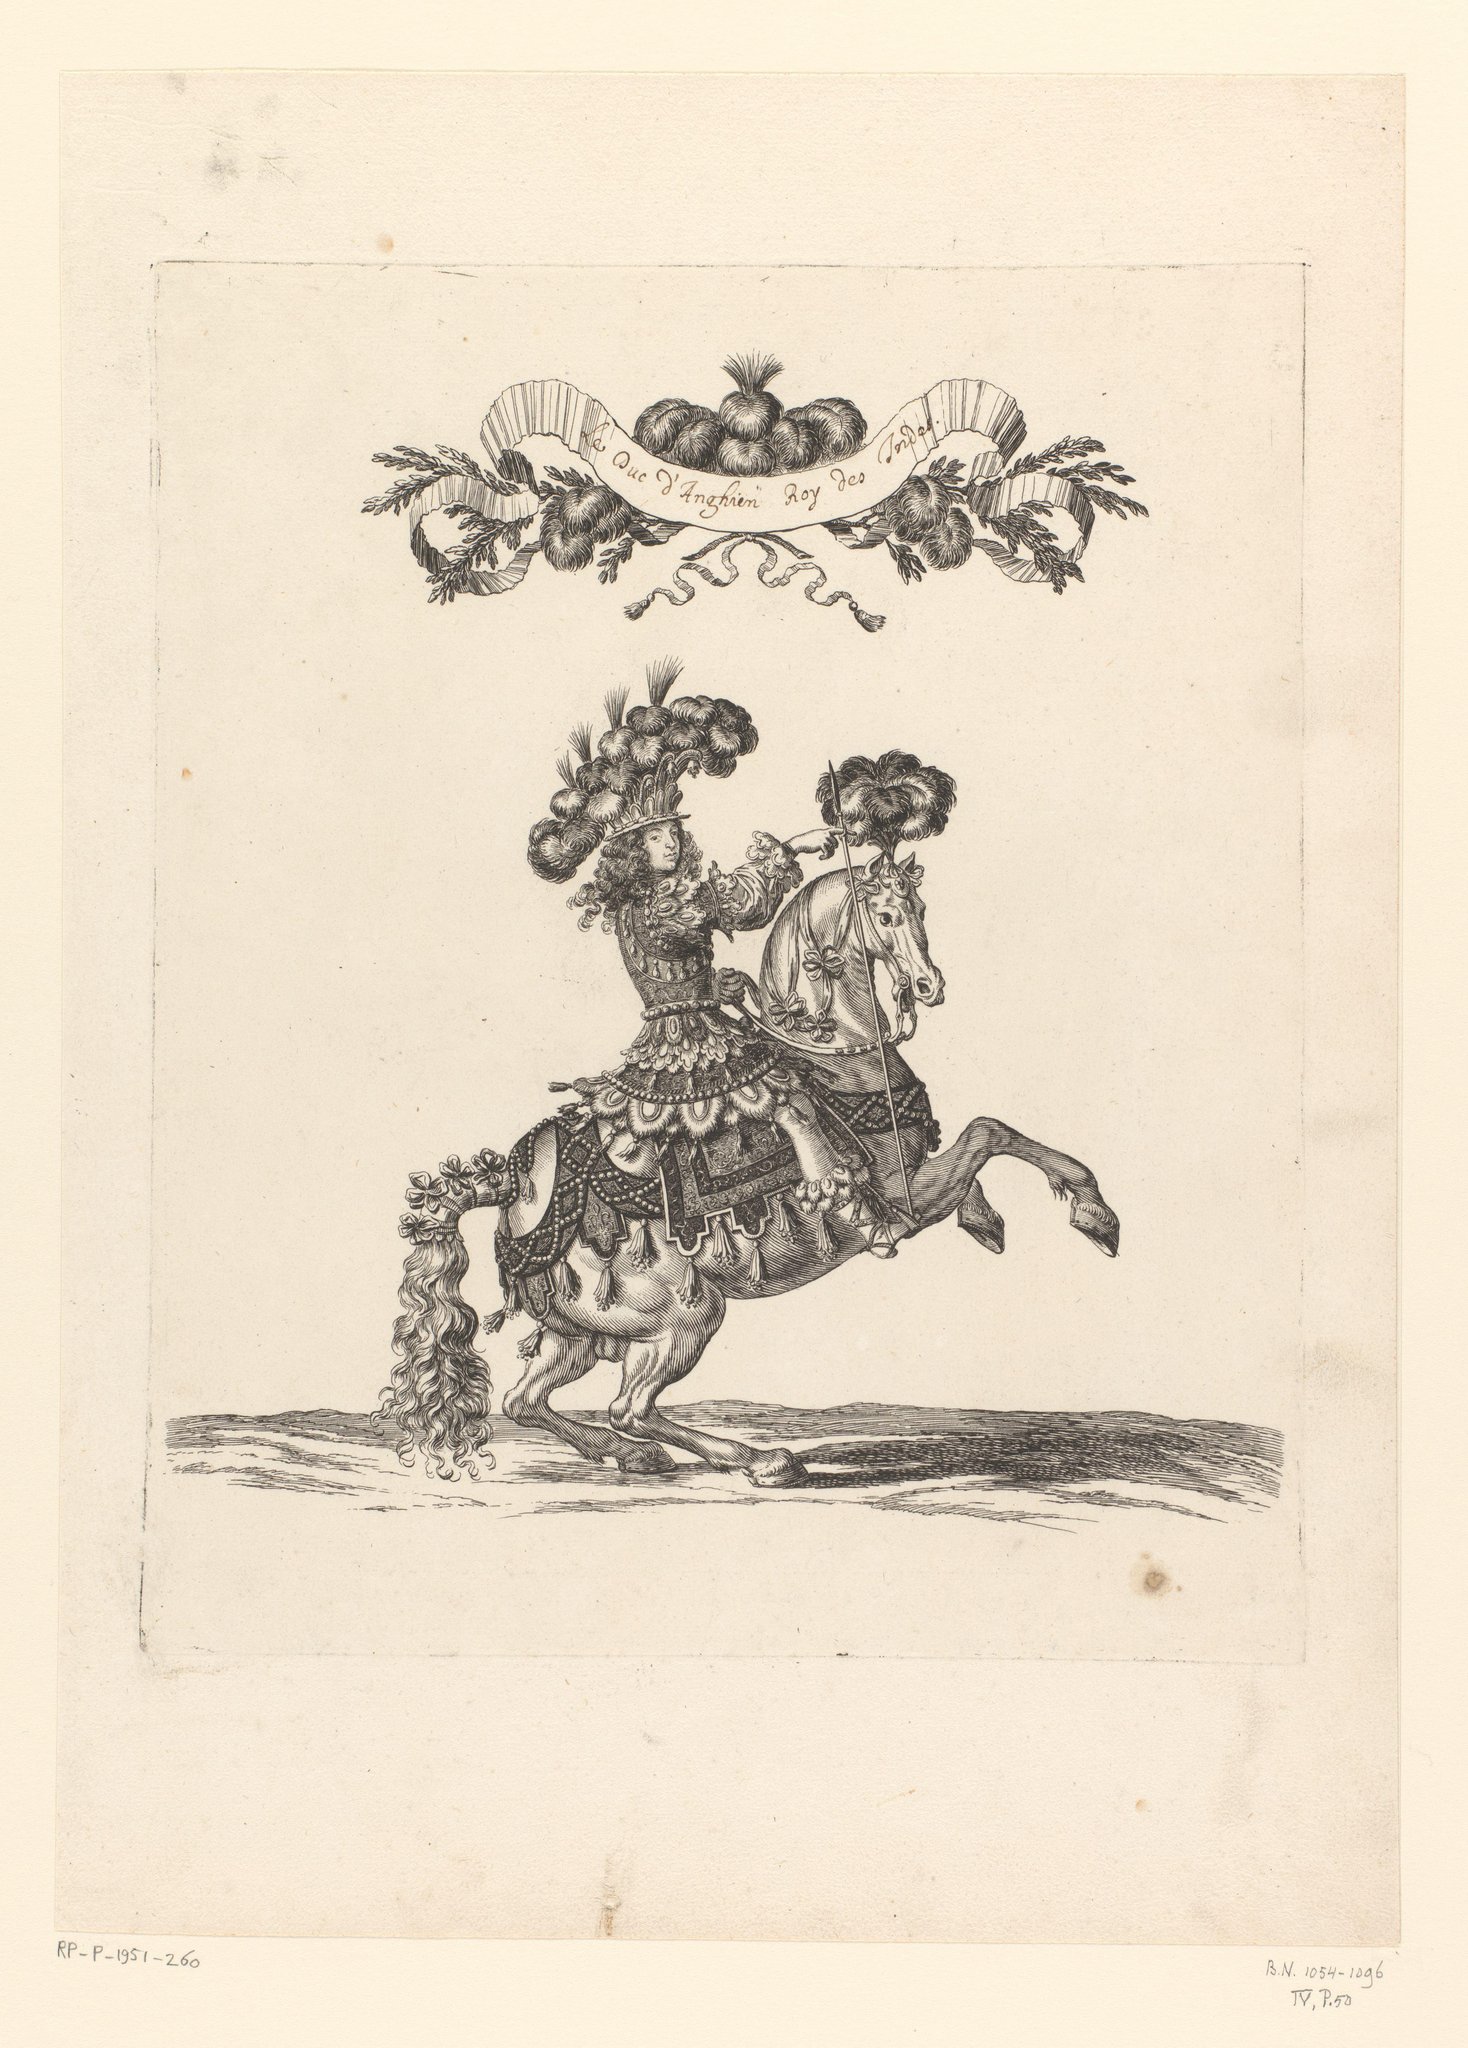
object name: book illustration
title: Le Duc d'Anghien, Roy des Indes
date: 1670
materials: paper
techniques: etching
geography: paris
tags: paris, dress-up party, indigenous peoples of north america (+ costume), tournament, prince, historical persons, horse, festivities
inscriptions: collector's mark: Lugt 2228, inscription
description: Prent uit: Perrault, Charles. Courses de testes et de bague faites par le Roy et par les princes et seigneurs de sa cour en l'année M.DC.LXII. Parijs: Imprimerie Royale, 1670. De prenten illustreren de door Lodewijk XIV georganiseerde festiviteiten in juni 1662 te Tuileries, zoals steekspelen met figuren in verschillende kostuums.